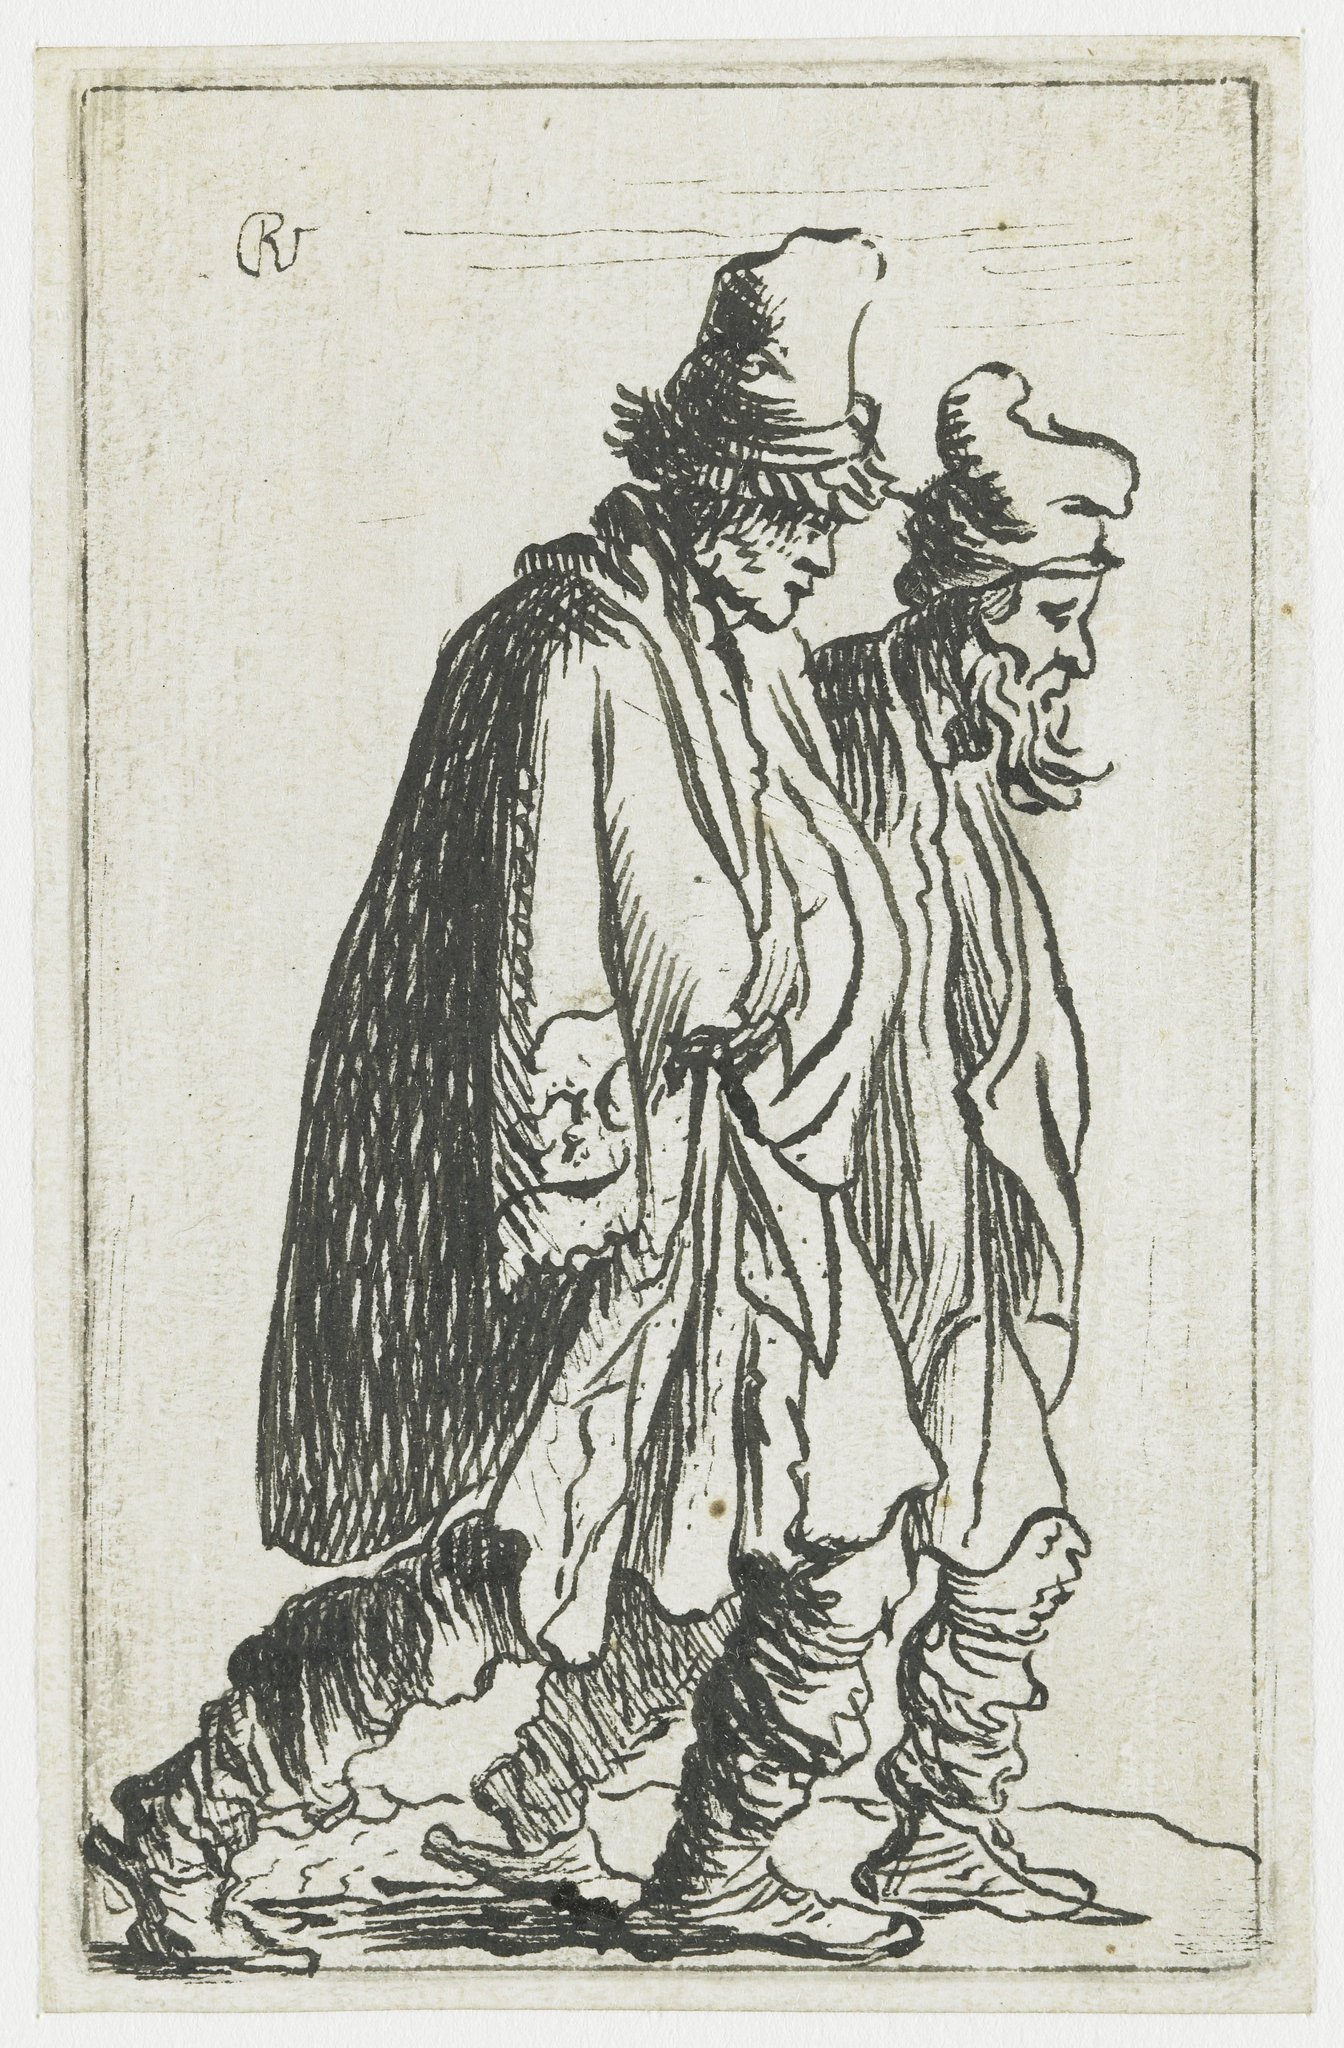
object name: drawing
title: Two beggars tramping towards the right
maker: Anonymous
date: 1629-1633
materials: ink, paper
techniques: pen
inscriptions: mark: Lugt 2228, mark: Lugt 58, monogram: ‘Rt’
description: Spiegelbeeldige kopie naar de gelijknamige prent van Rembrandt.